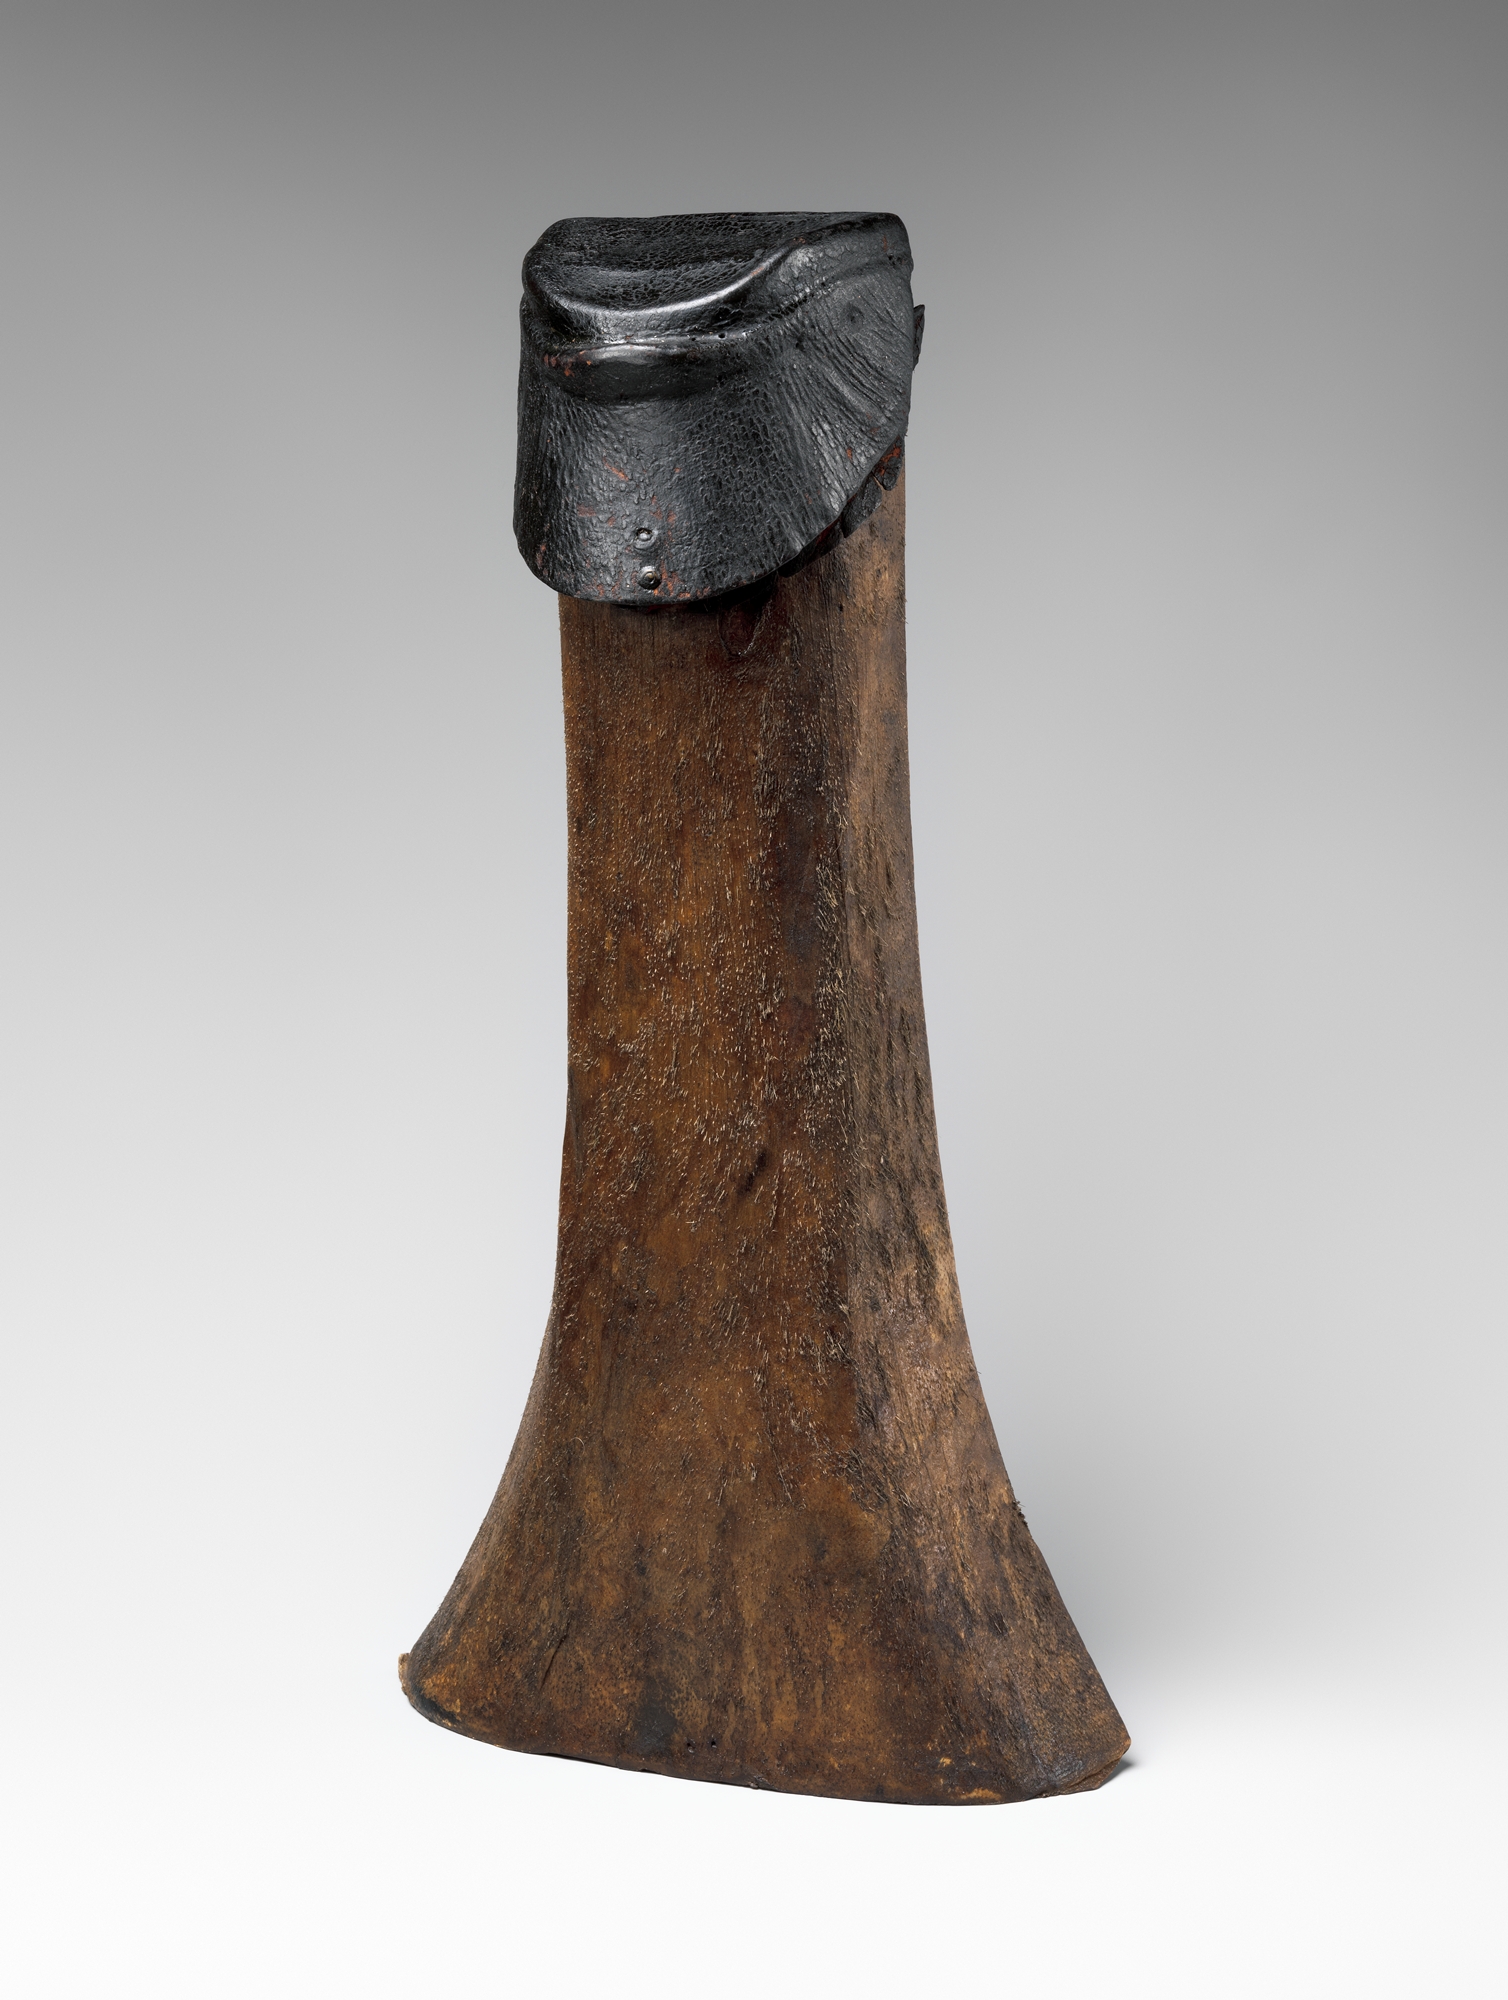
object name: quiver with eleven crossbow bolt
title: Quiver with Eleven Crossbow Bolts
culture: central or western european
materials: metal alloy, leather, paper, steel, wood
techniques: tanning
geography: germany